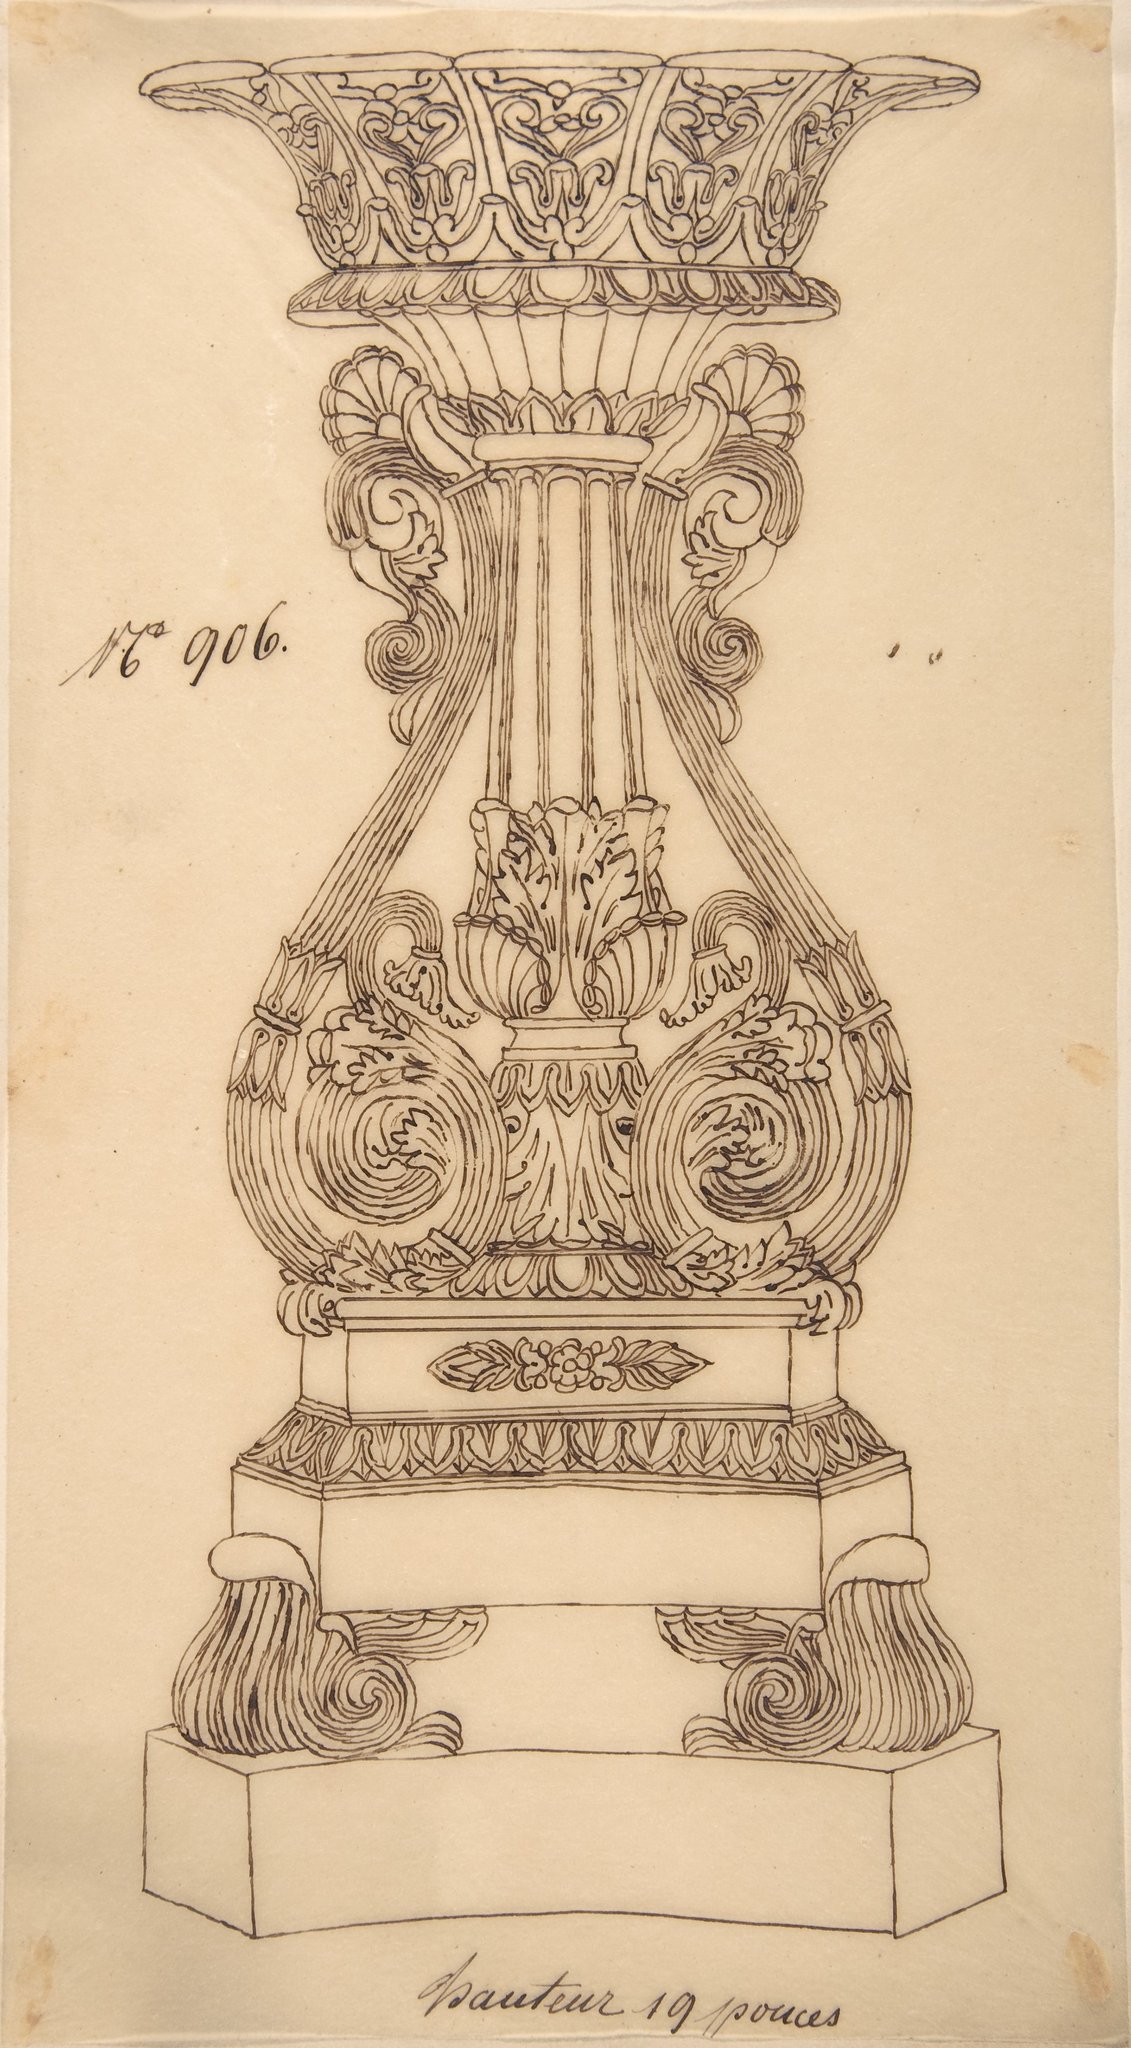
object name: drawing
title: Design for a Candlestick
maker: anonymous, french, 19th century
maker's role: artist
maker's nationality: french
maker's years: 1800-1900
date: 1801-1900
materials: ink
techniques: pen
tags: candlesticks